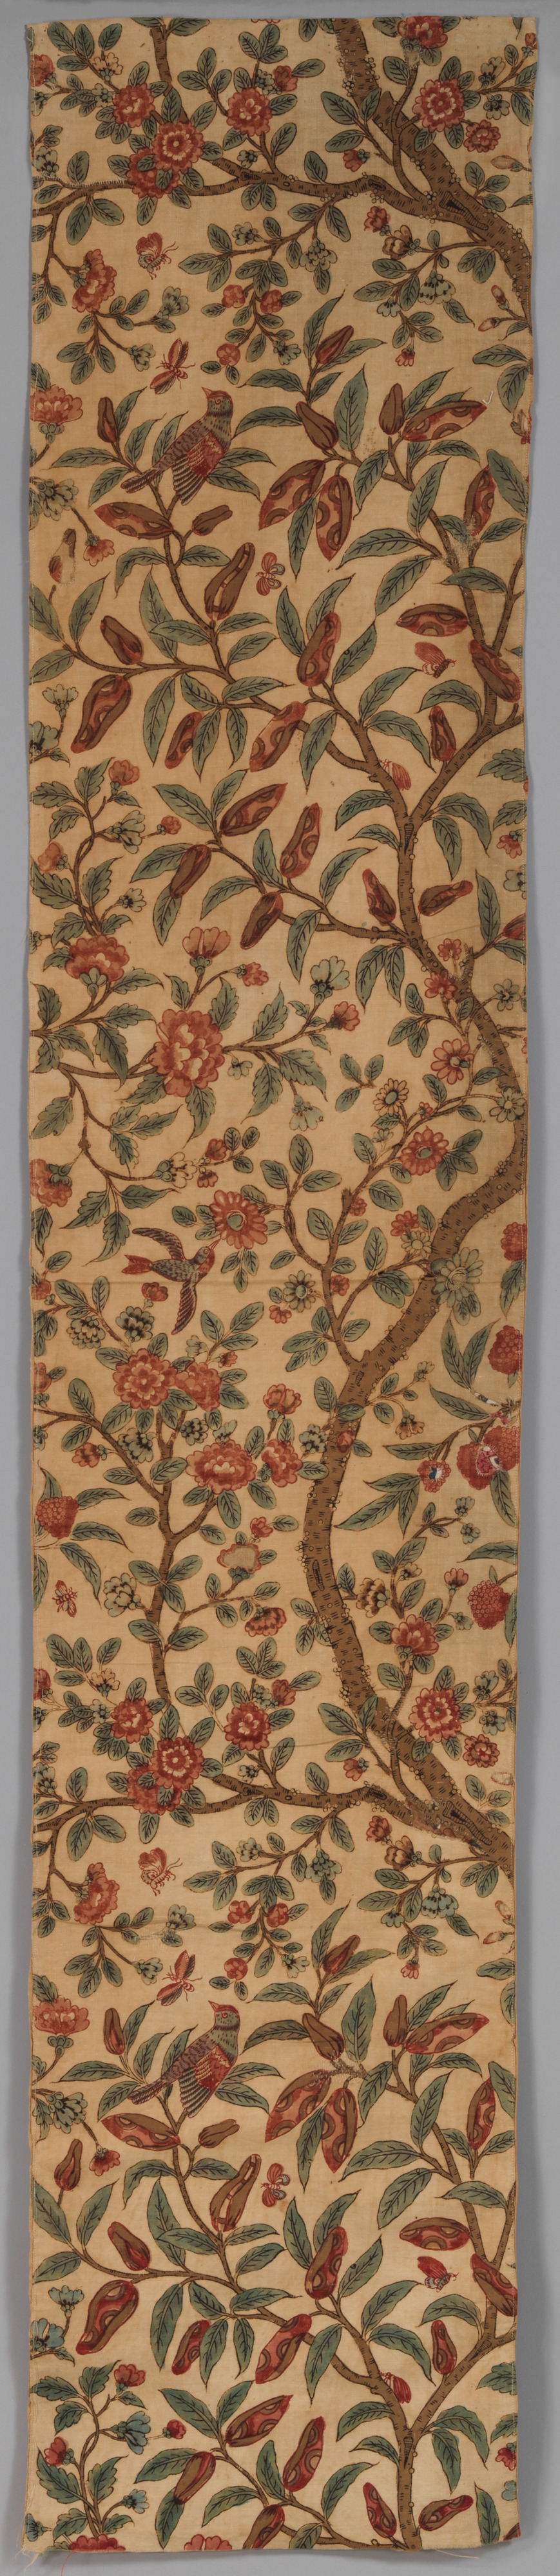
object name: fragment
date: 1767-1800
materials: cotton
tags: flowers,leaves